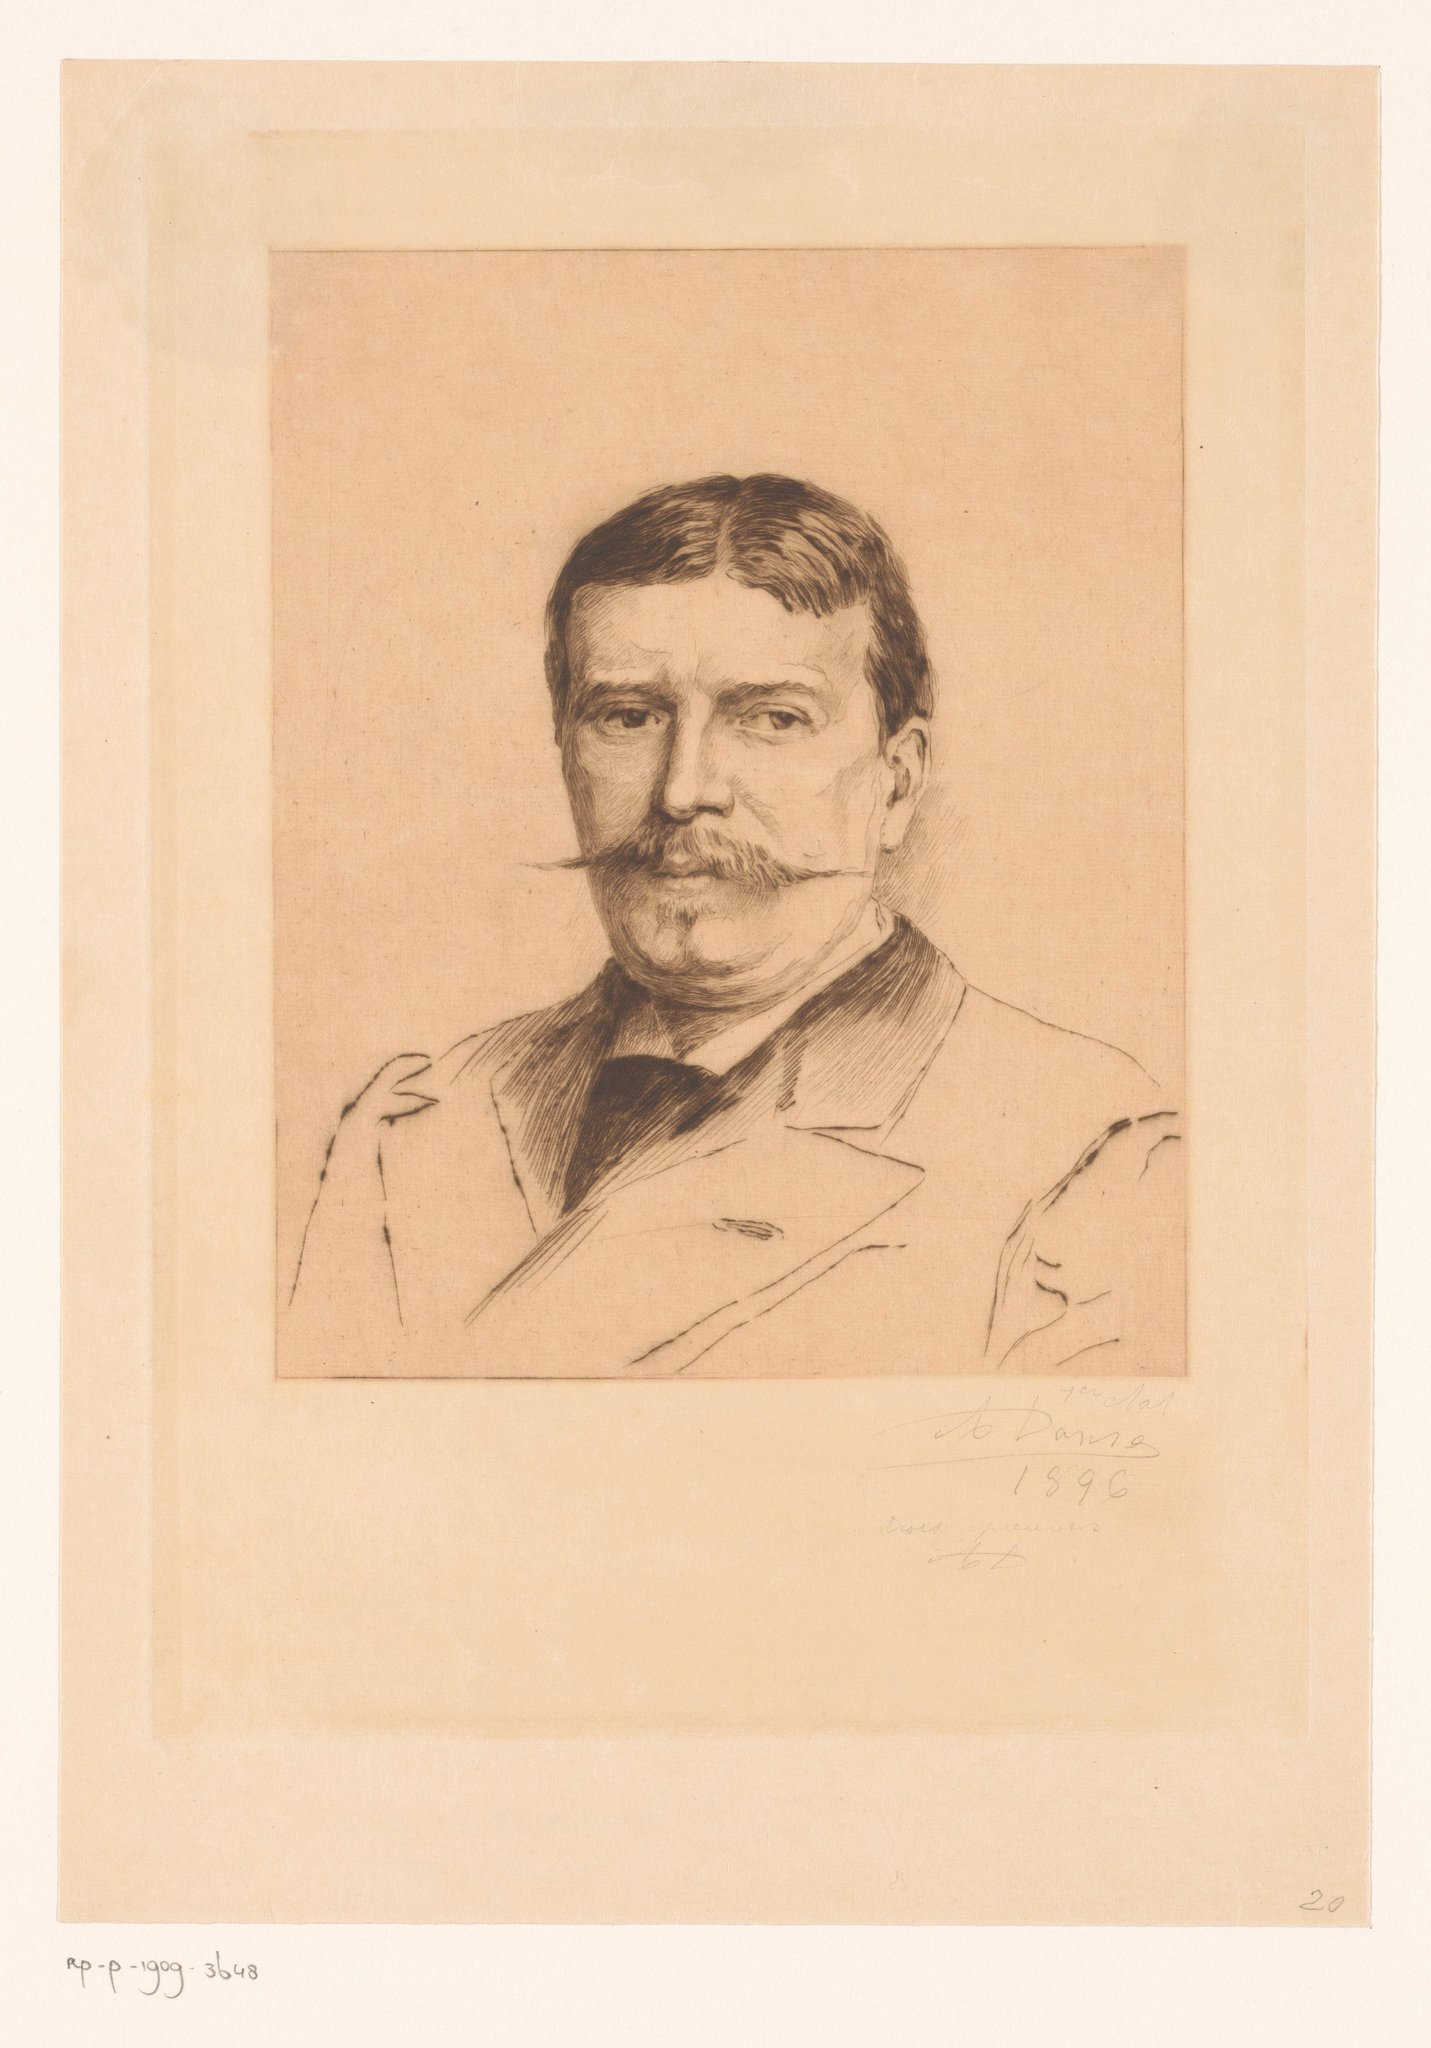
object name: print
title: Portret van een Belgische advocaat, mogelijk Paul Spitaëls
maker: auguste danse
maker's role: print maker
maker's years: 1829-1929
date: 1896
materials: paper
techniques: drypoint, etching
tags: anonymous historical person portrayed alone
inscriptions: collector's mark: Lugt 2228, annotation: ‘1er etat; trois epreuves’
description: De naam Spitaëls komt voor op een latere staat van deze prent.